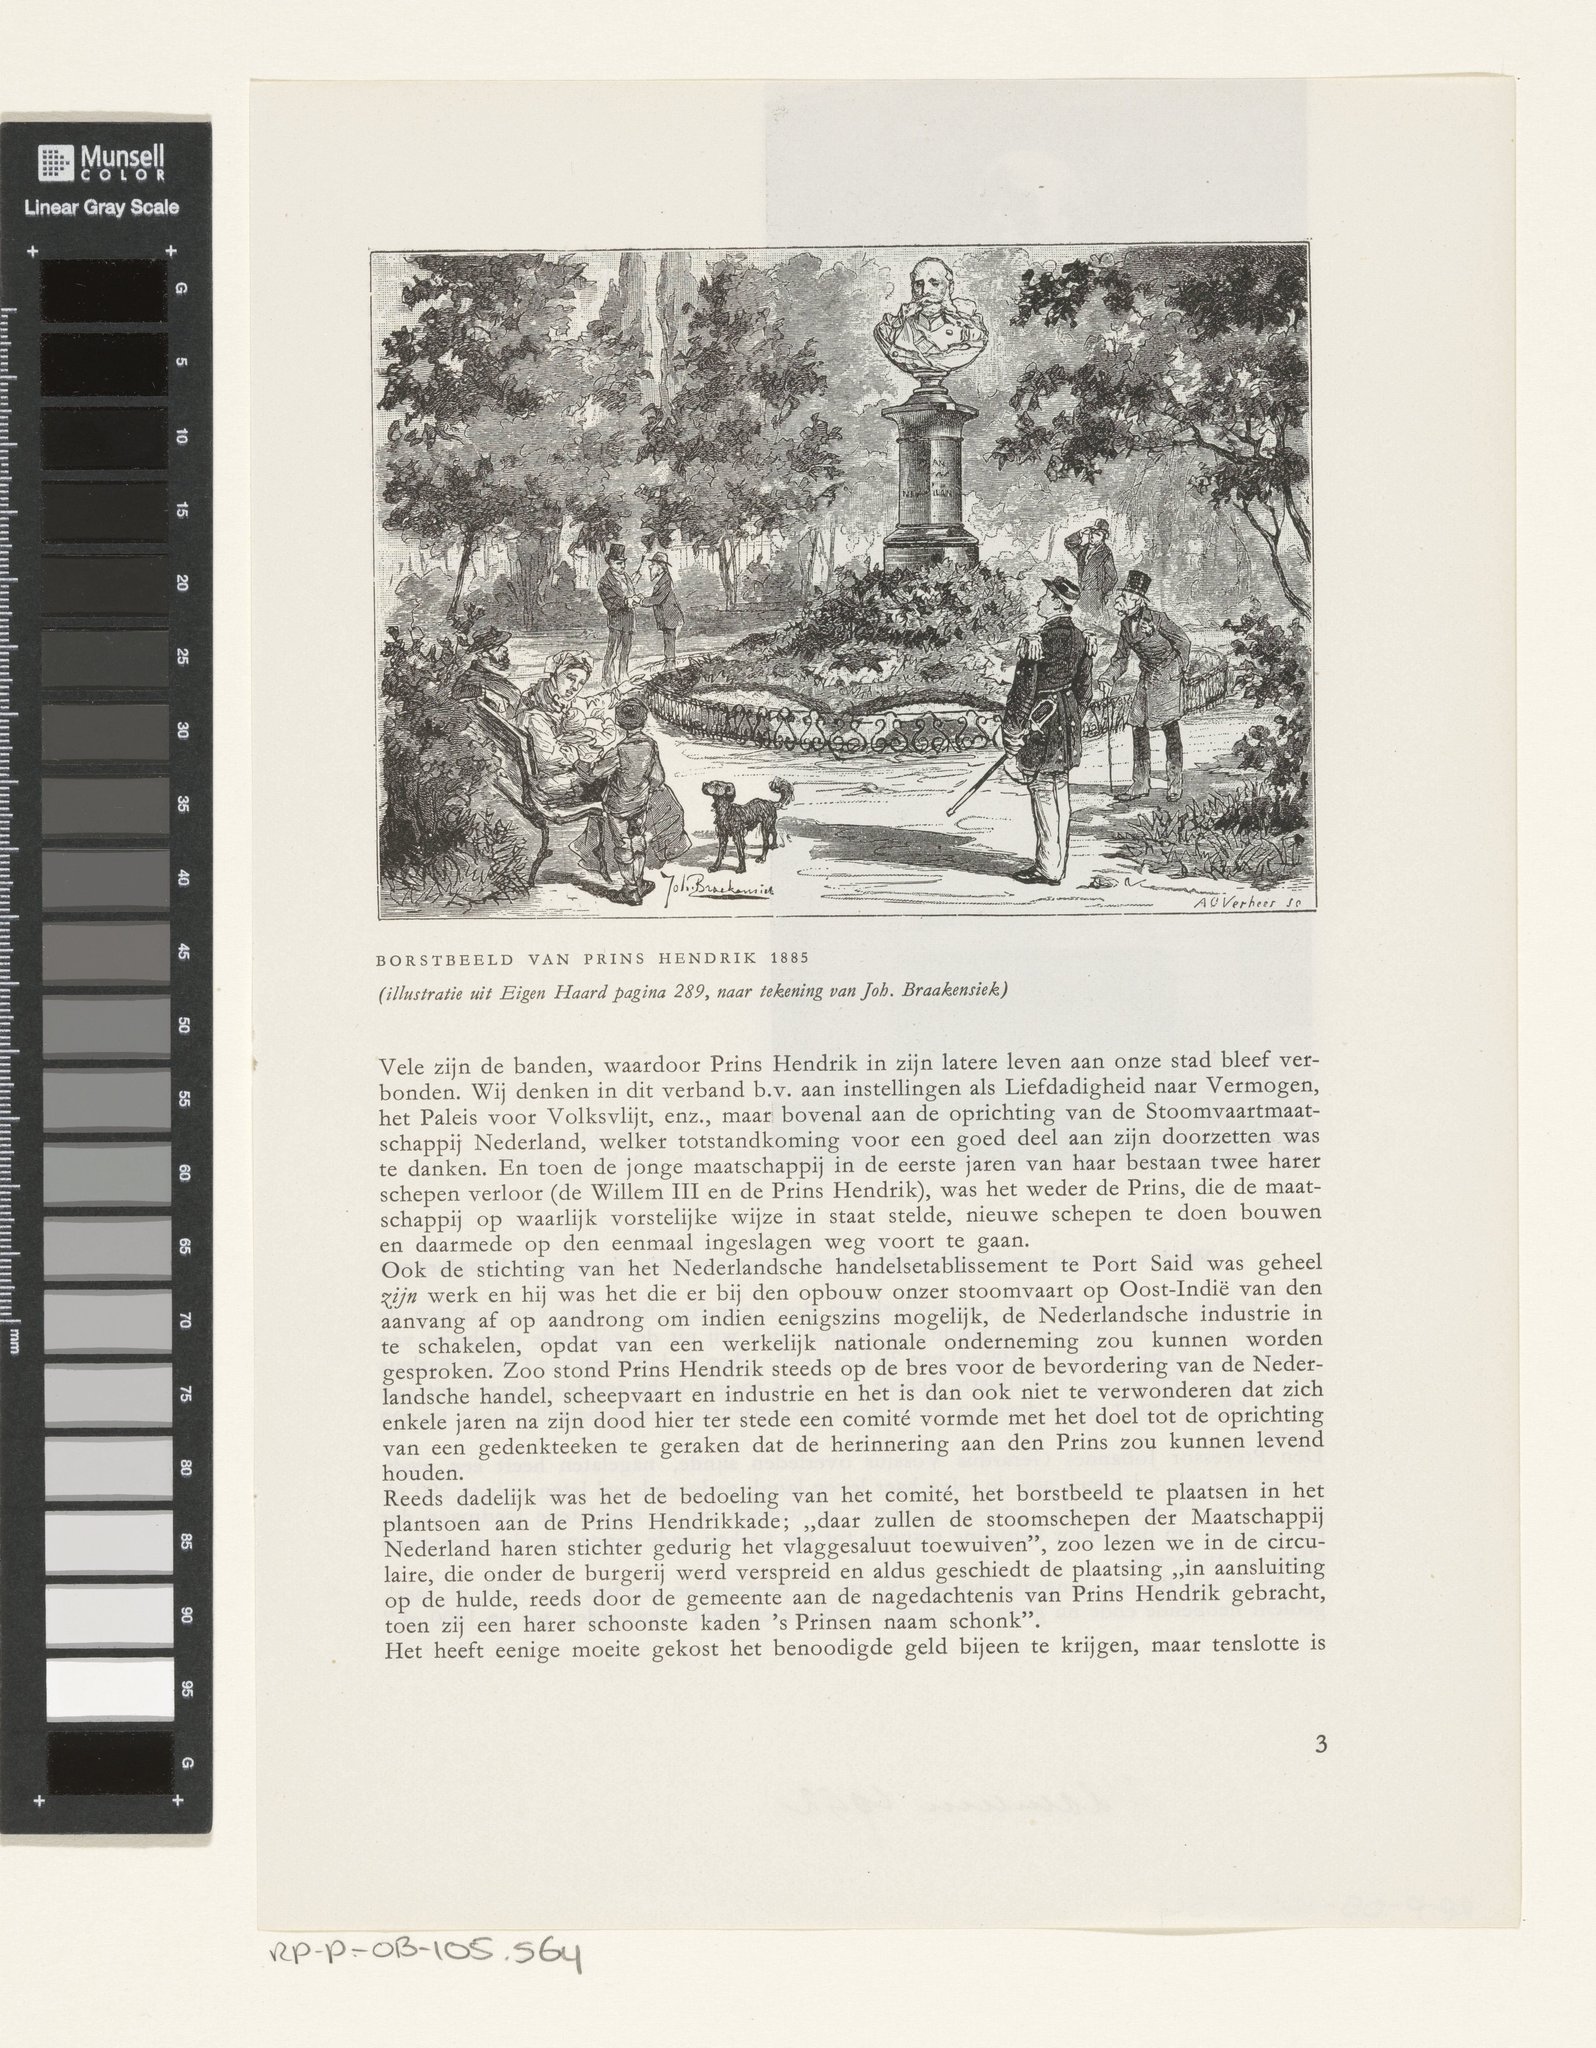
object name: print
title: Buste van Hendrik, prins der Nederlanden, op de Prins Hendrikkade te Amsterdam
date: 1885-1929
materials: paper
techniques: letterpress printing, engraving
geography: den bosch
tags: hendrik (prins der nederlanden), piece of sculpture, reproduction of a piece of sculpture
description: De hier vermelde titel verwijst naar de hoogst verkregen titel van de geportretteerde, niet per se naar de titel die de geportretteerde op deze voorstelling draagt.